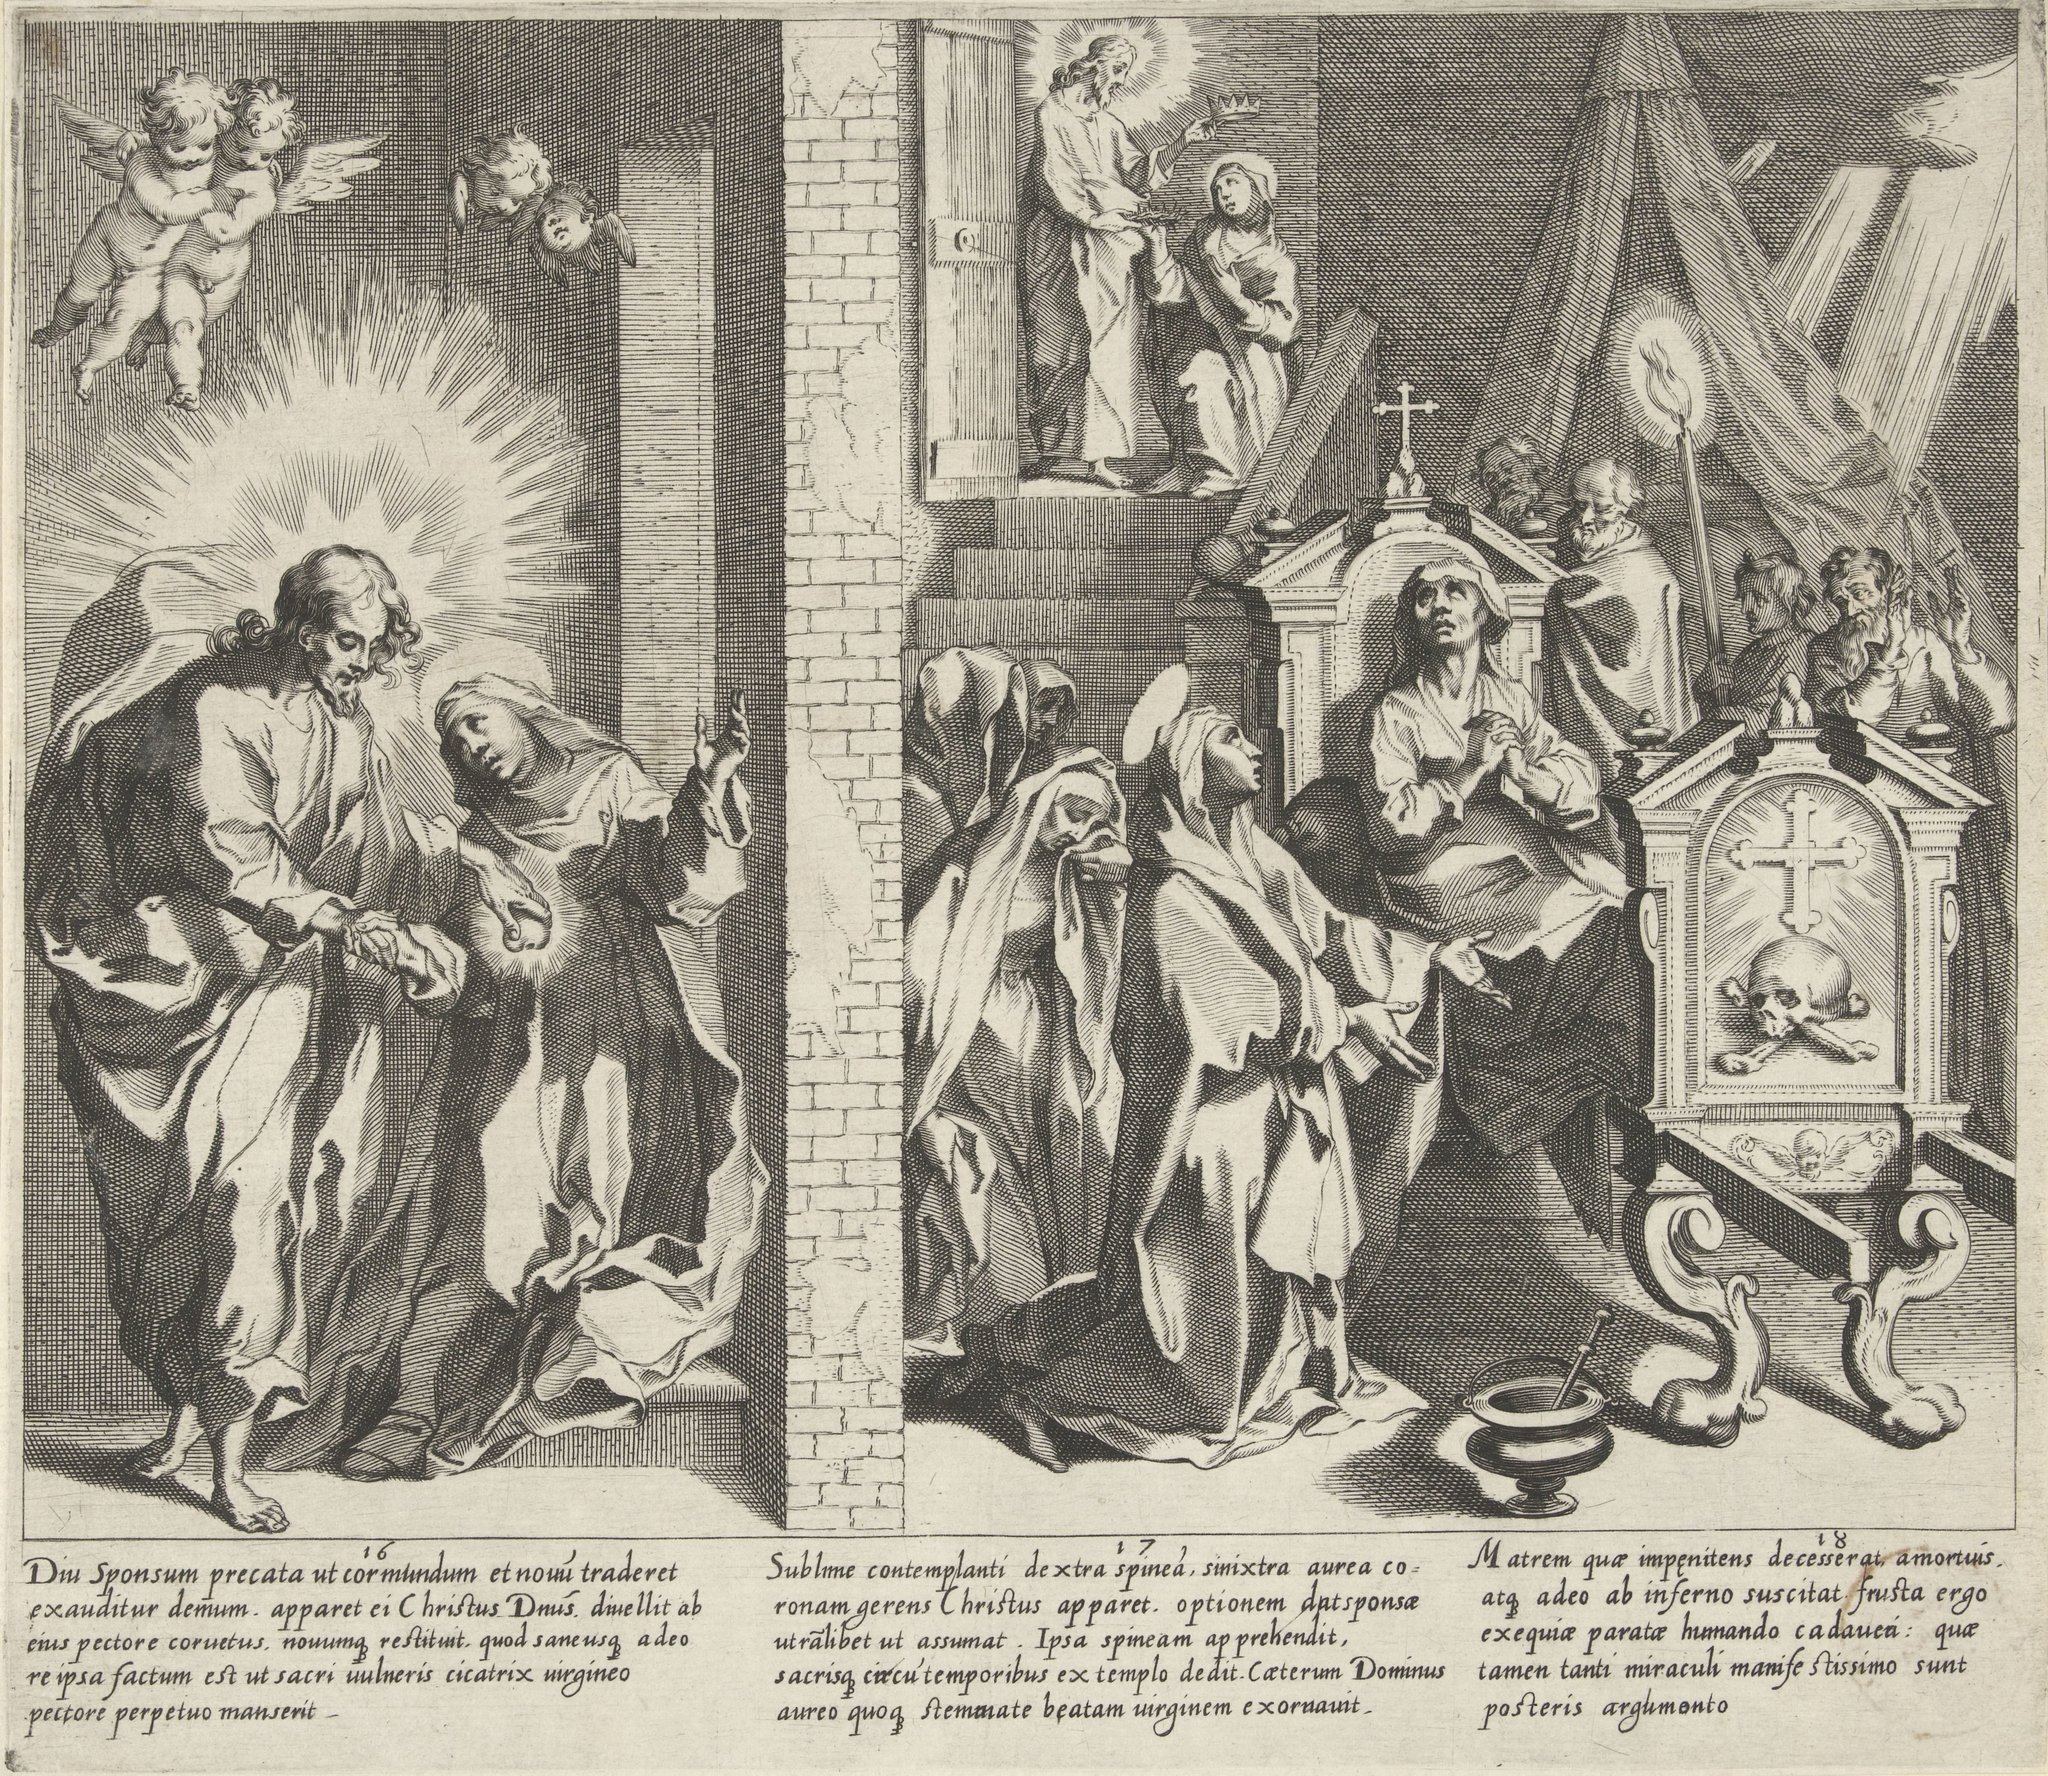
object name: print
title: Scènes uit het leven en wonderen van de Heilige Catharina van Siena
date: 1597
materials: paper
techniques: engraving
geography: italy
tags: the virgin and dominican tertiary, catherine of siena; possible attributes: book, cross, crown of thorns, crucifix, demon under foot, heart (with cross), lily, plague-stricken, ring, rosary, stigmata, st. catherine of siena changing hearts with christ, christ offering st. catherine of siena the choice between two crowns, one of gold and jewels, and one of thorns; st. catherine, kneeling before him, takes the crown of thorns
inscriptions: collector's mark: Lugt 240